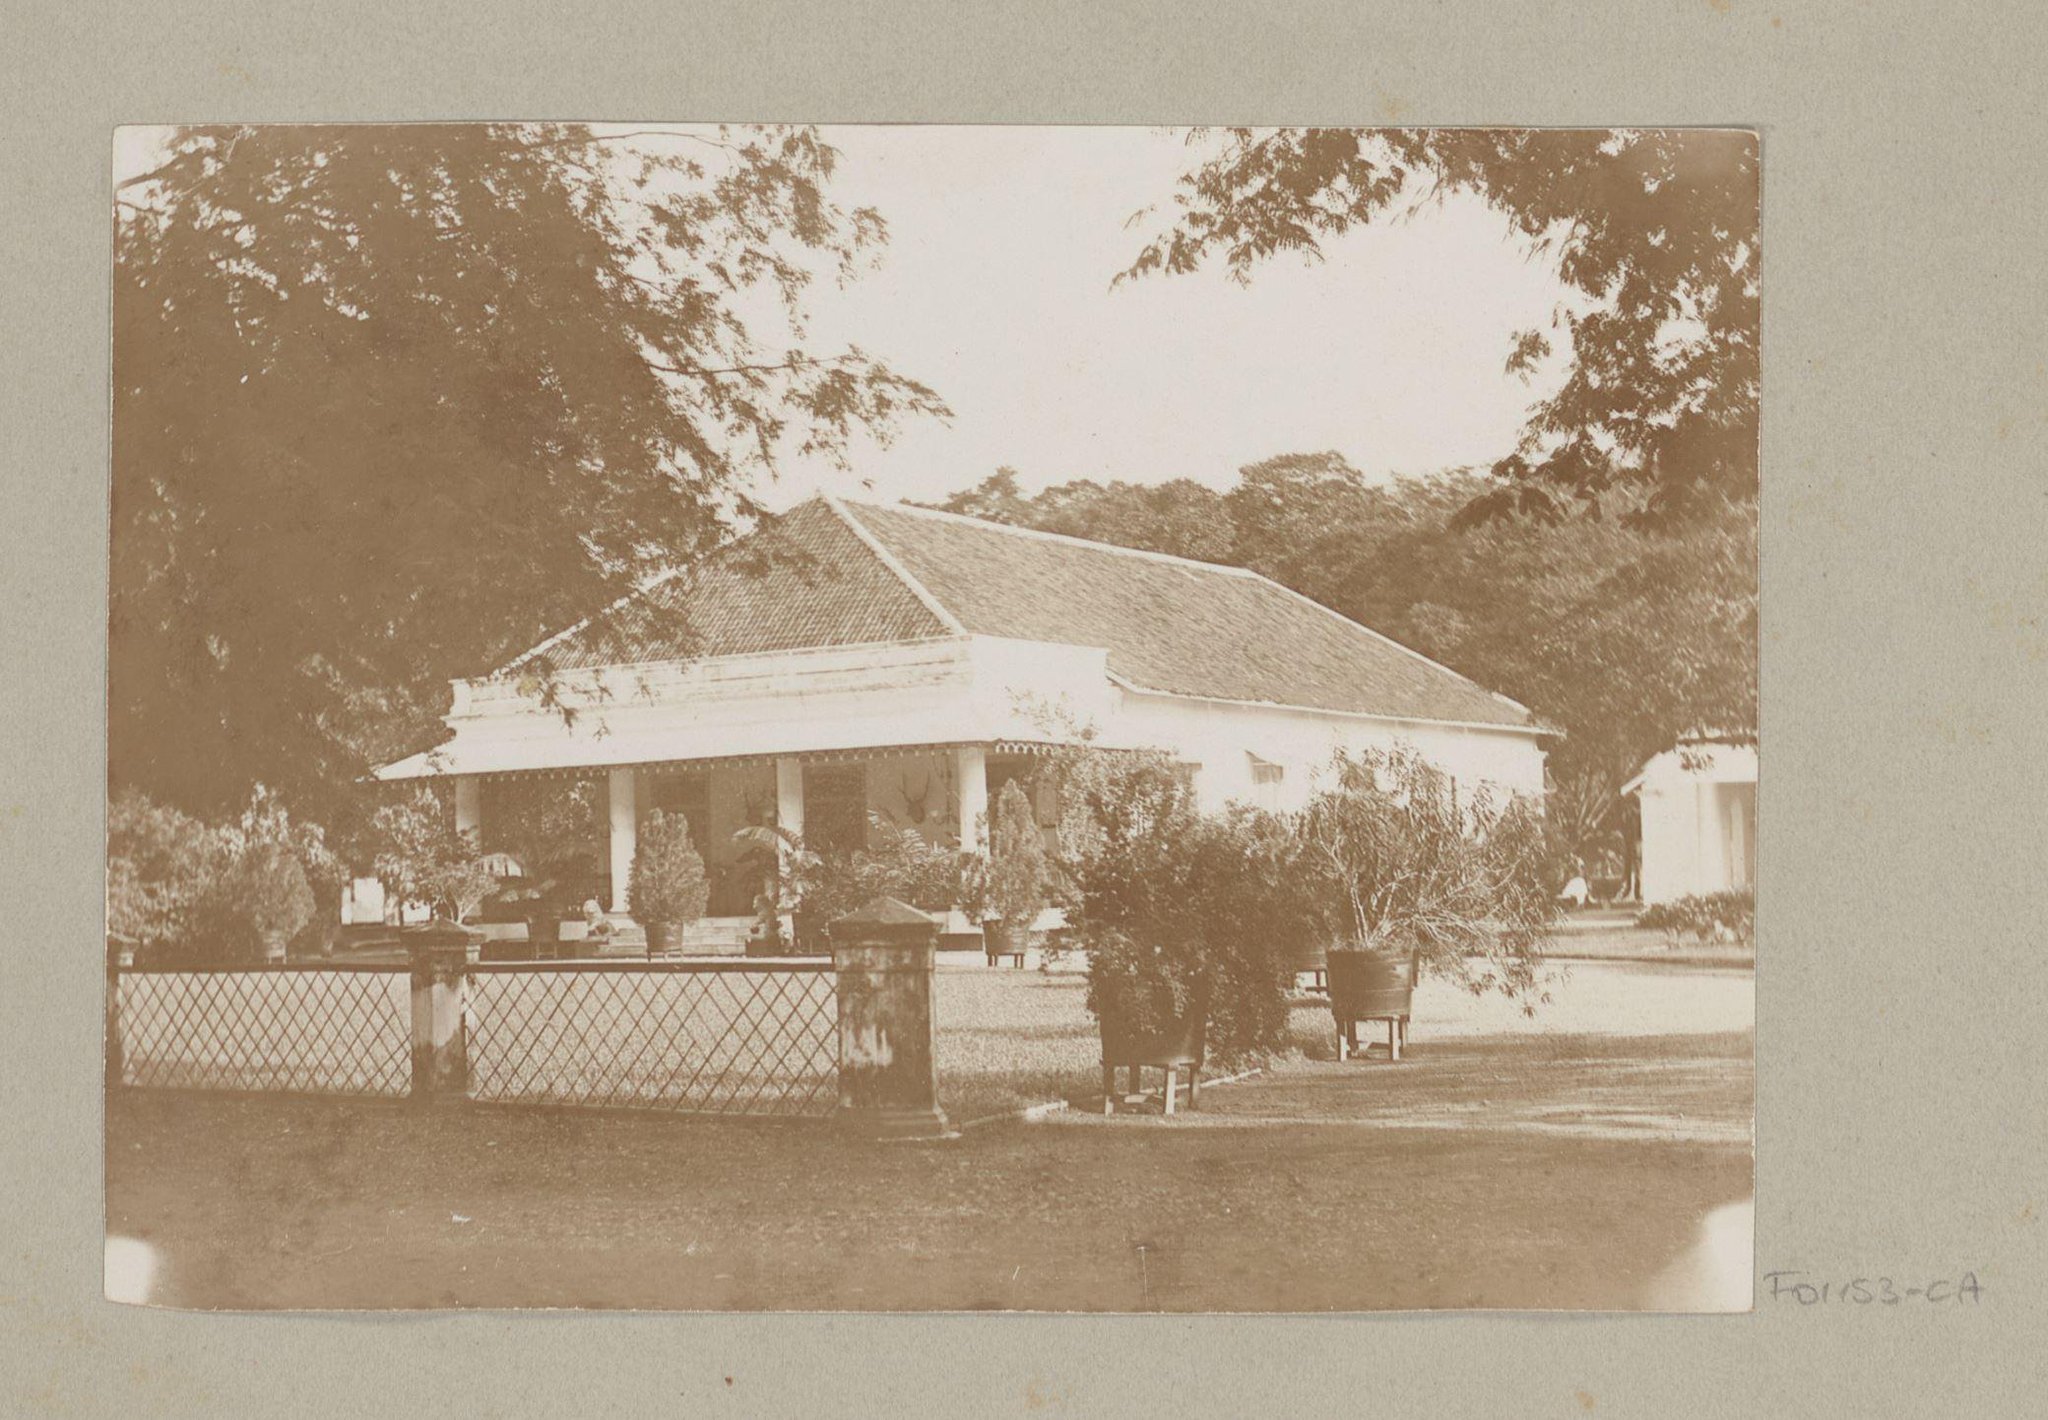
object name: photograph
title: Huis met tuin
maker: Anonymous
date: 1880-1900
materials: photographic support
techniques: collodion silver print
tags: garden, rural housing, e.g. country-house, villa, cottage, dutch east indies, the